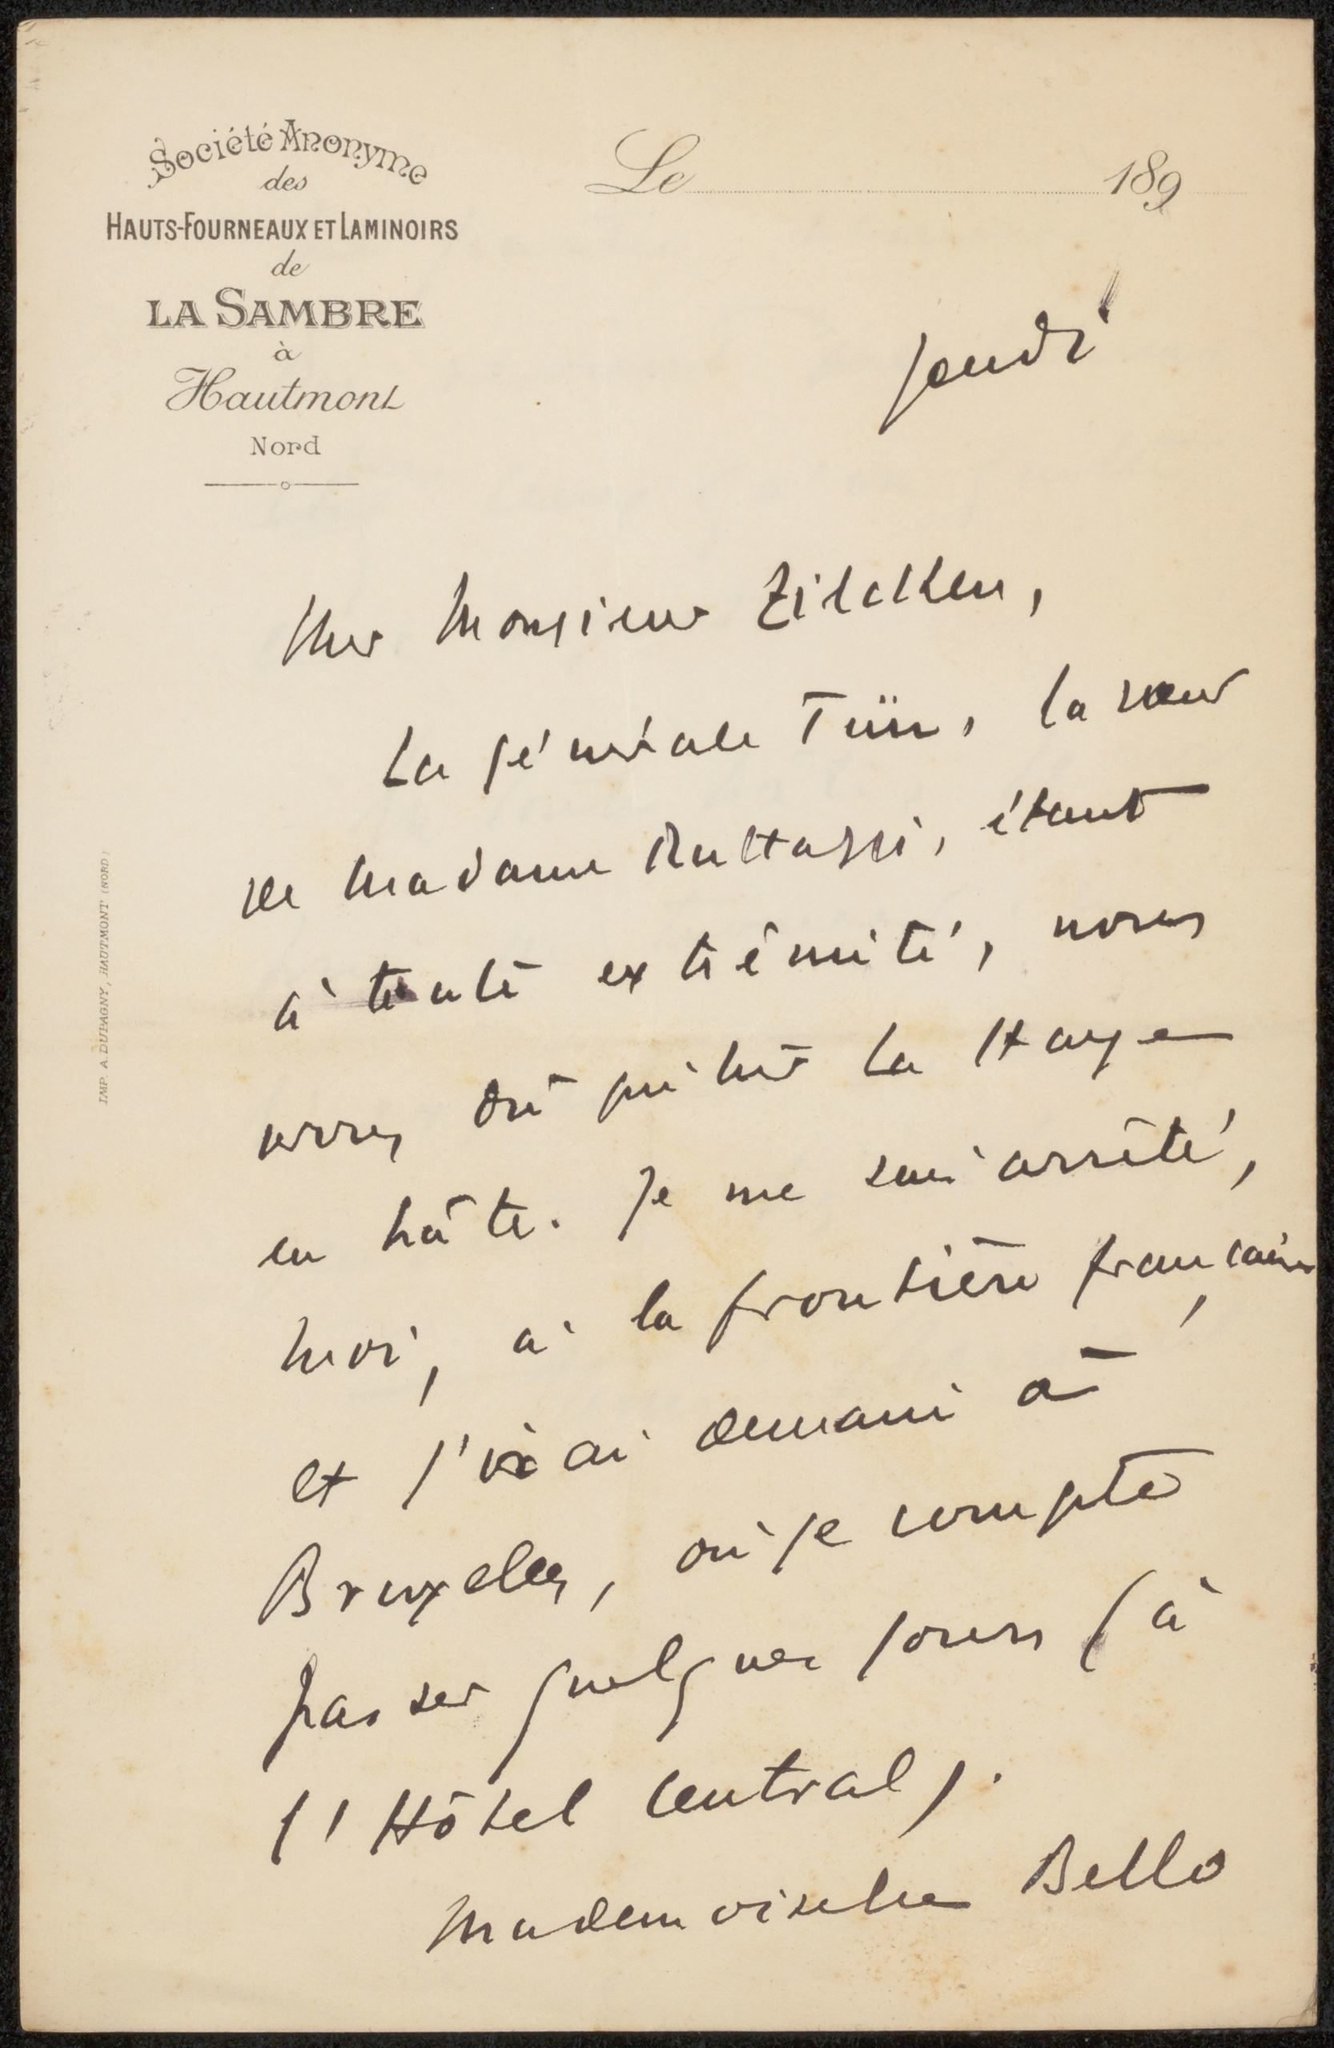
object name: letter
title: Brief aan Philip Zilcken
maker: henri charriant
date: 1867-1930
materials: ink, paper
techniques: pen, printing, writing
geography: hautmont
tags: the hague, painter, draughtsman, philip zilcken, brussels, paris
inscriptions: collector's mark: ‘RPK’